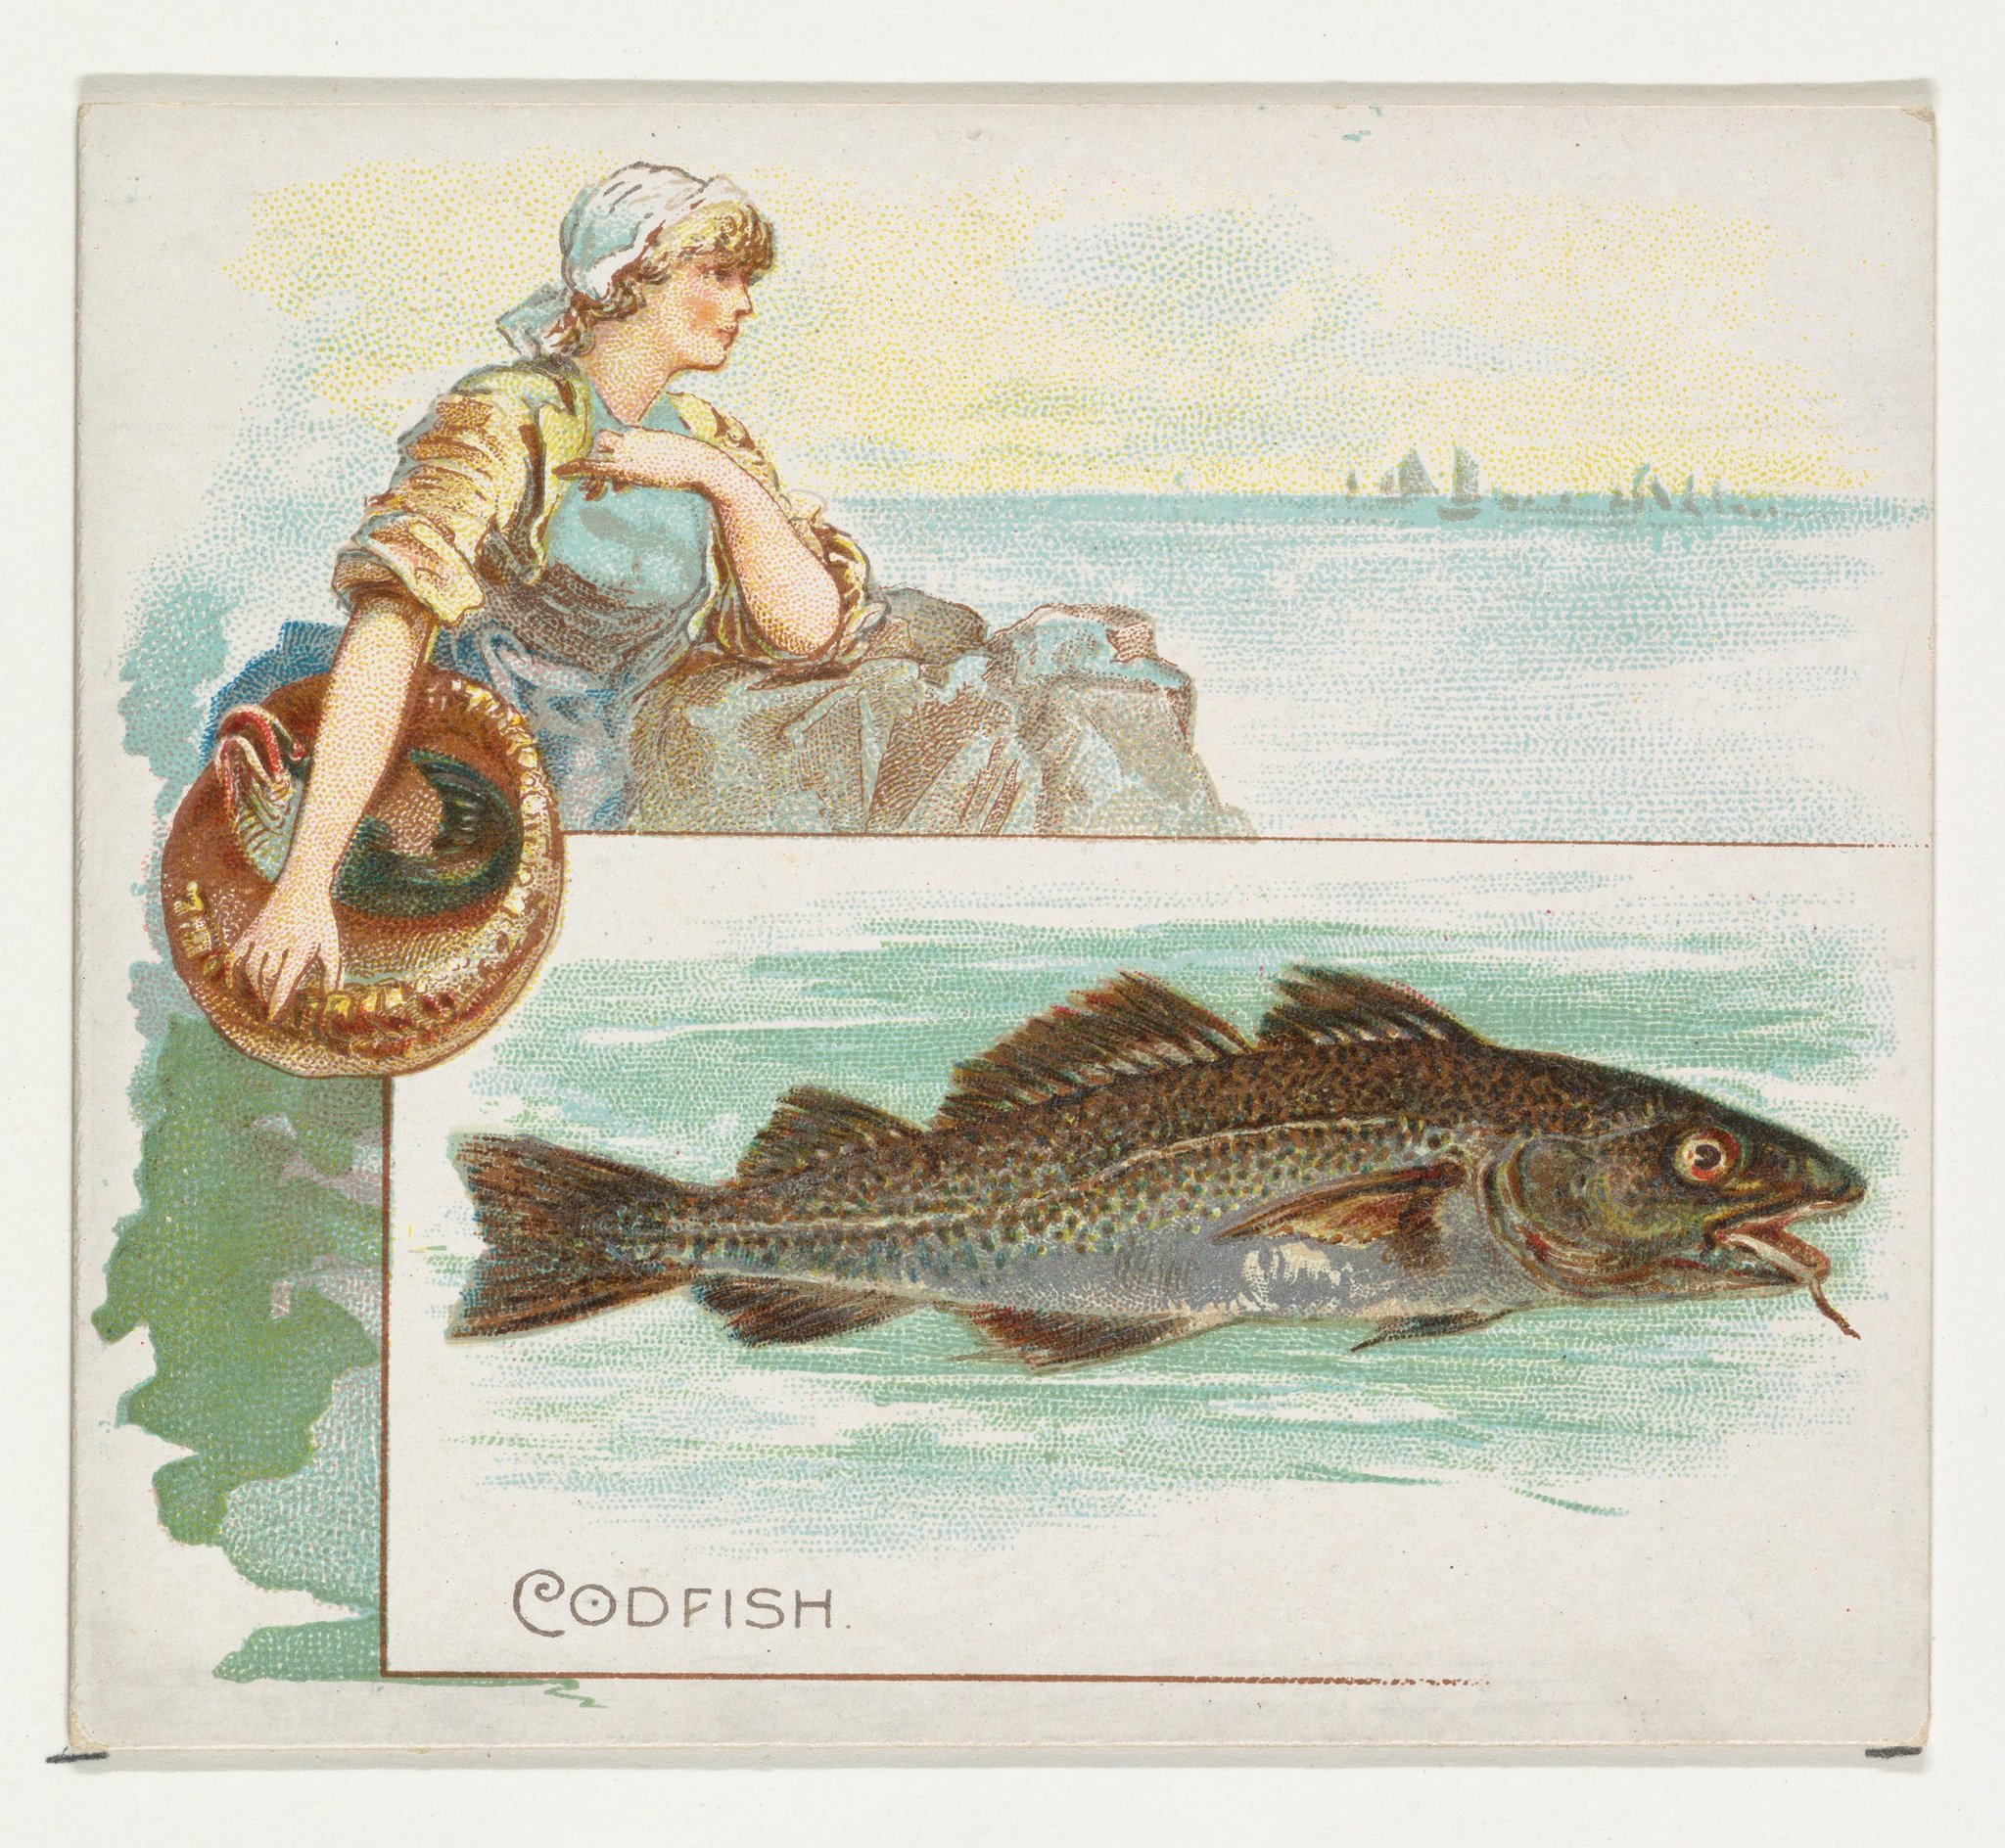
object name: print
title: Codfish, from Fish from American Waters series (N39) for Allen & Ginter Cigarettes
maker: allen & ginter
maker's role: publisher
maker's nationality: american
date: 1889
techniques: color lithograph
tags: women,fish